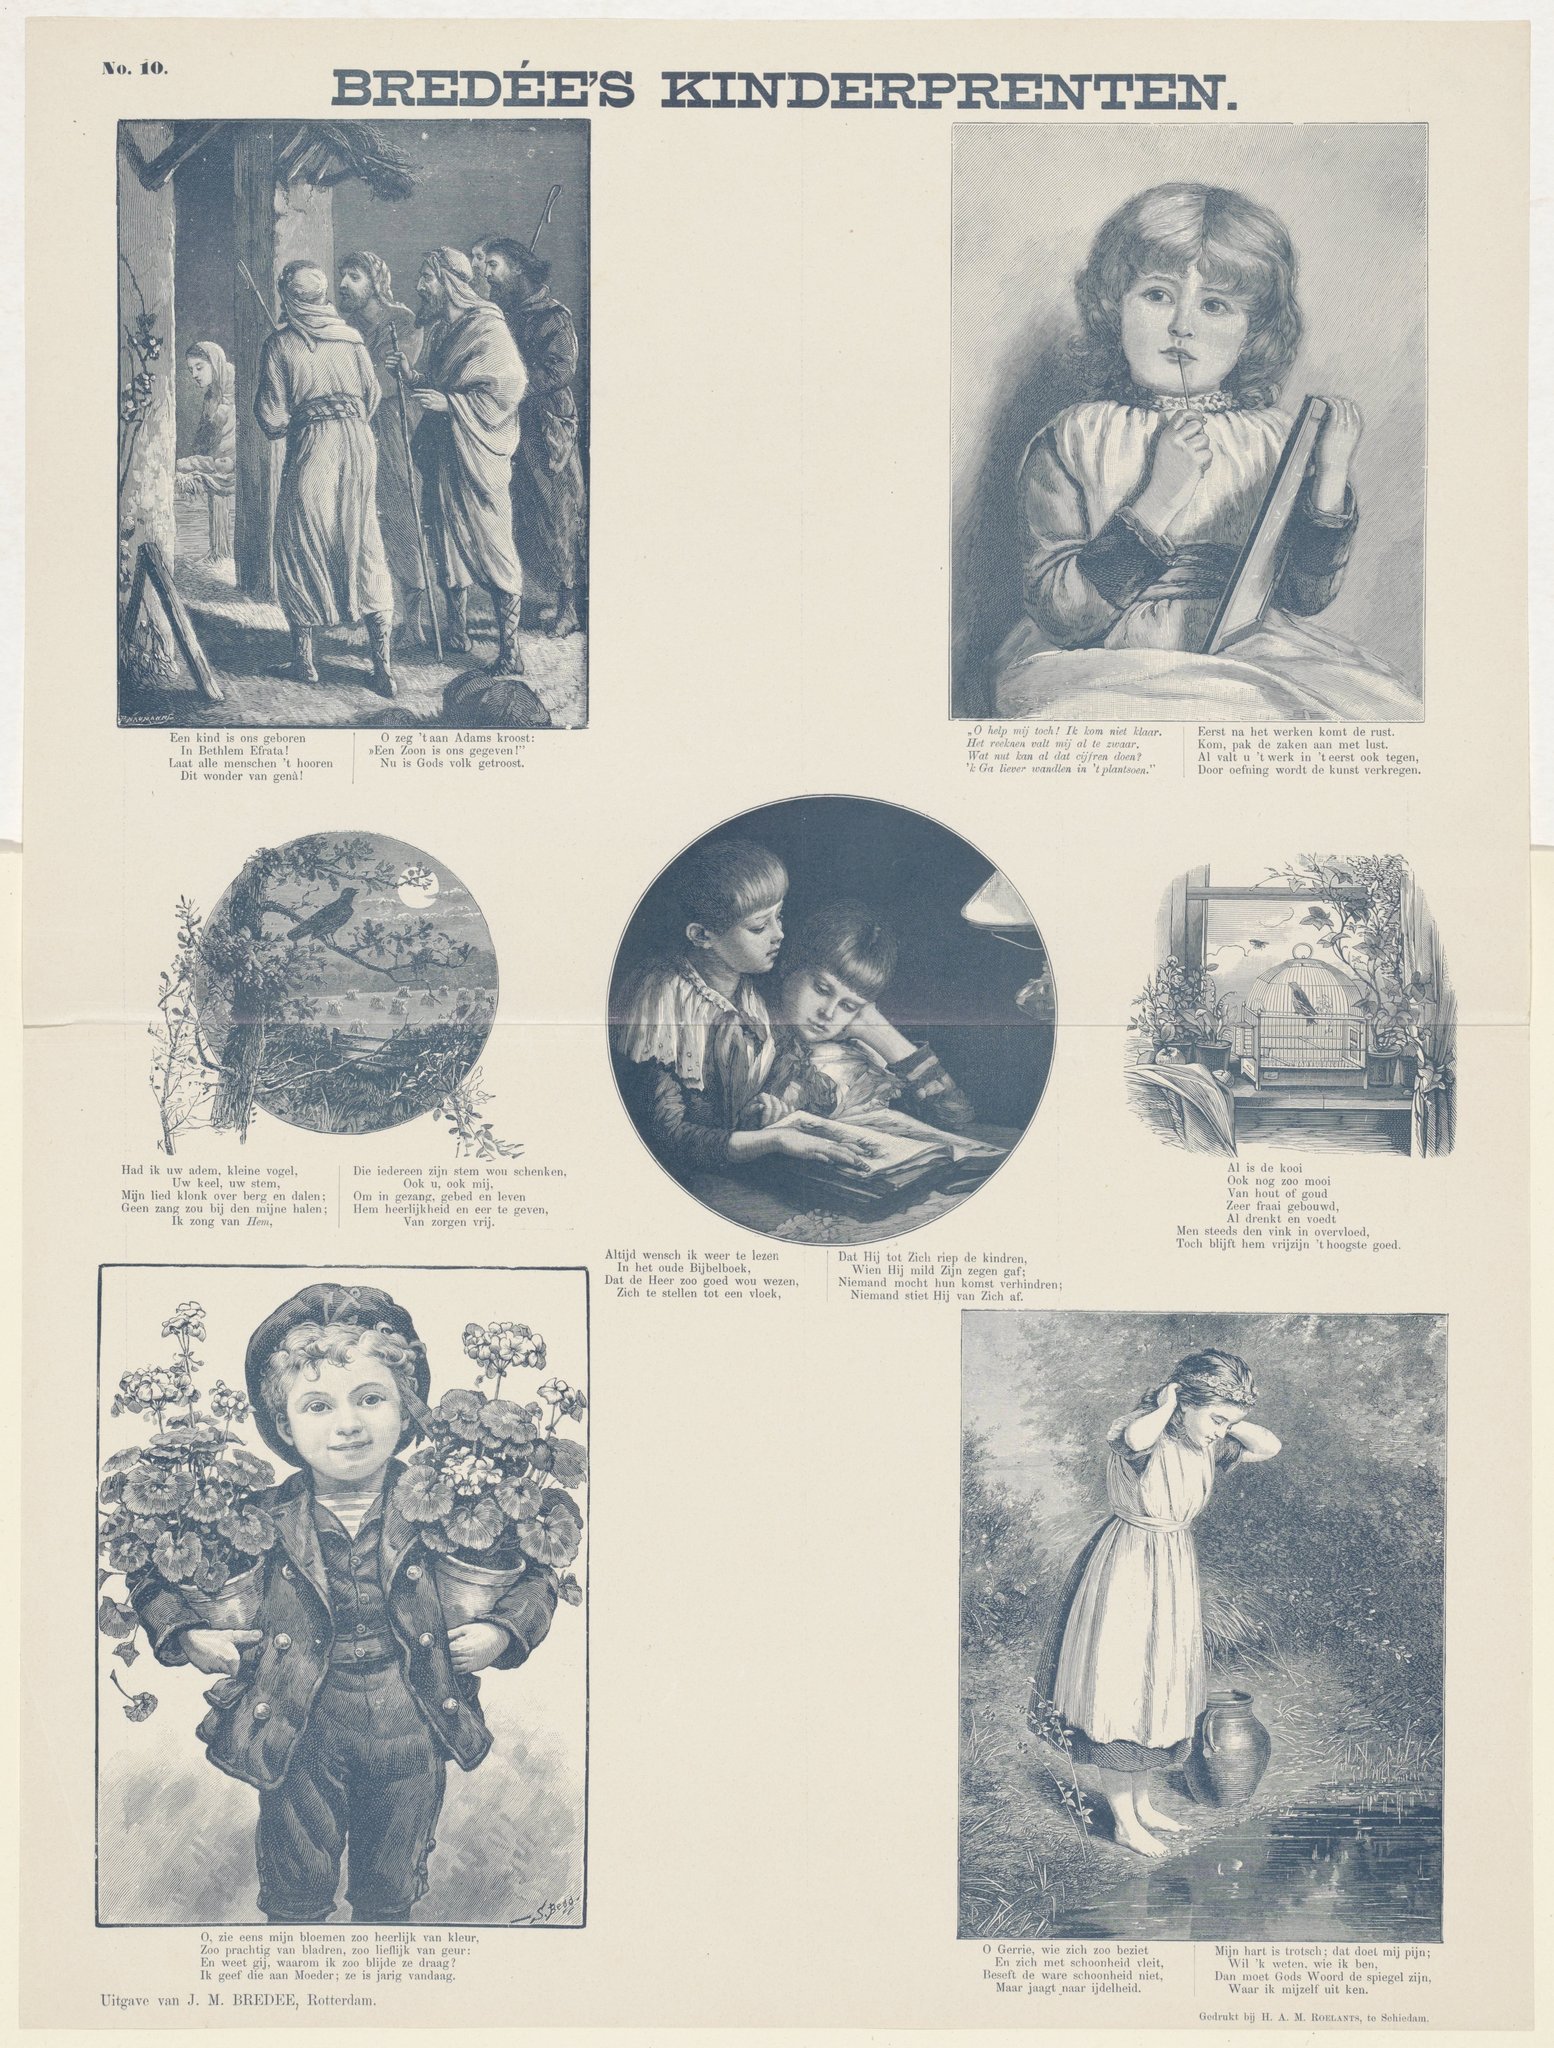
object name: popular print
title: Verschillende voorstellingen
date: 1894-1918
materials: paper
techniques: letterpress printing, line block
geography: schiedam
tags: adoration of the christ-child by the shepherds; mary and joseph present, child, bird in a cage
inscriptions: collector's mark: Lugt 2760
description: Blad met 7 voorstellingen van verschillende aard, waaronder voorstellingen van de aanbidding door de herders, een vogel in een kooi en een jongen met twee planten met bloemen in zijn armen. Onder elke afbeelding vier tot acht regels vers. Genummerd linksboven: No. 10.